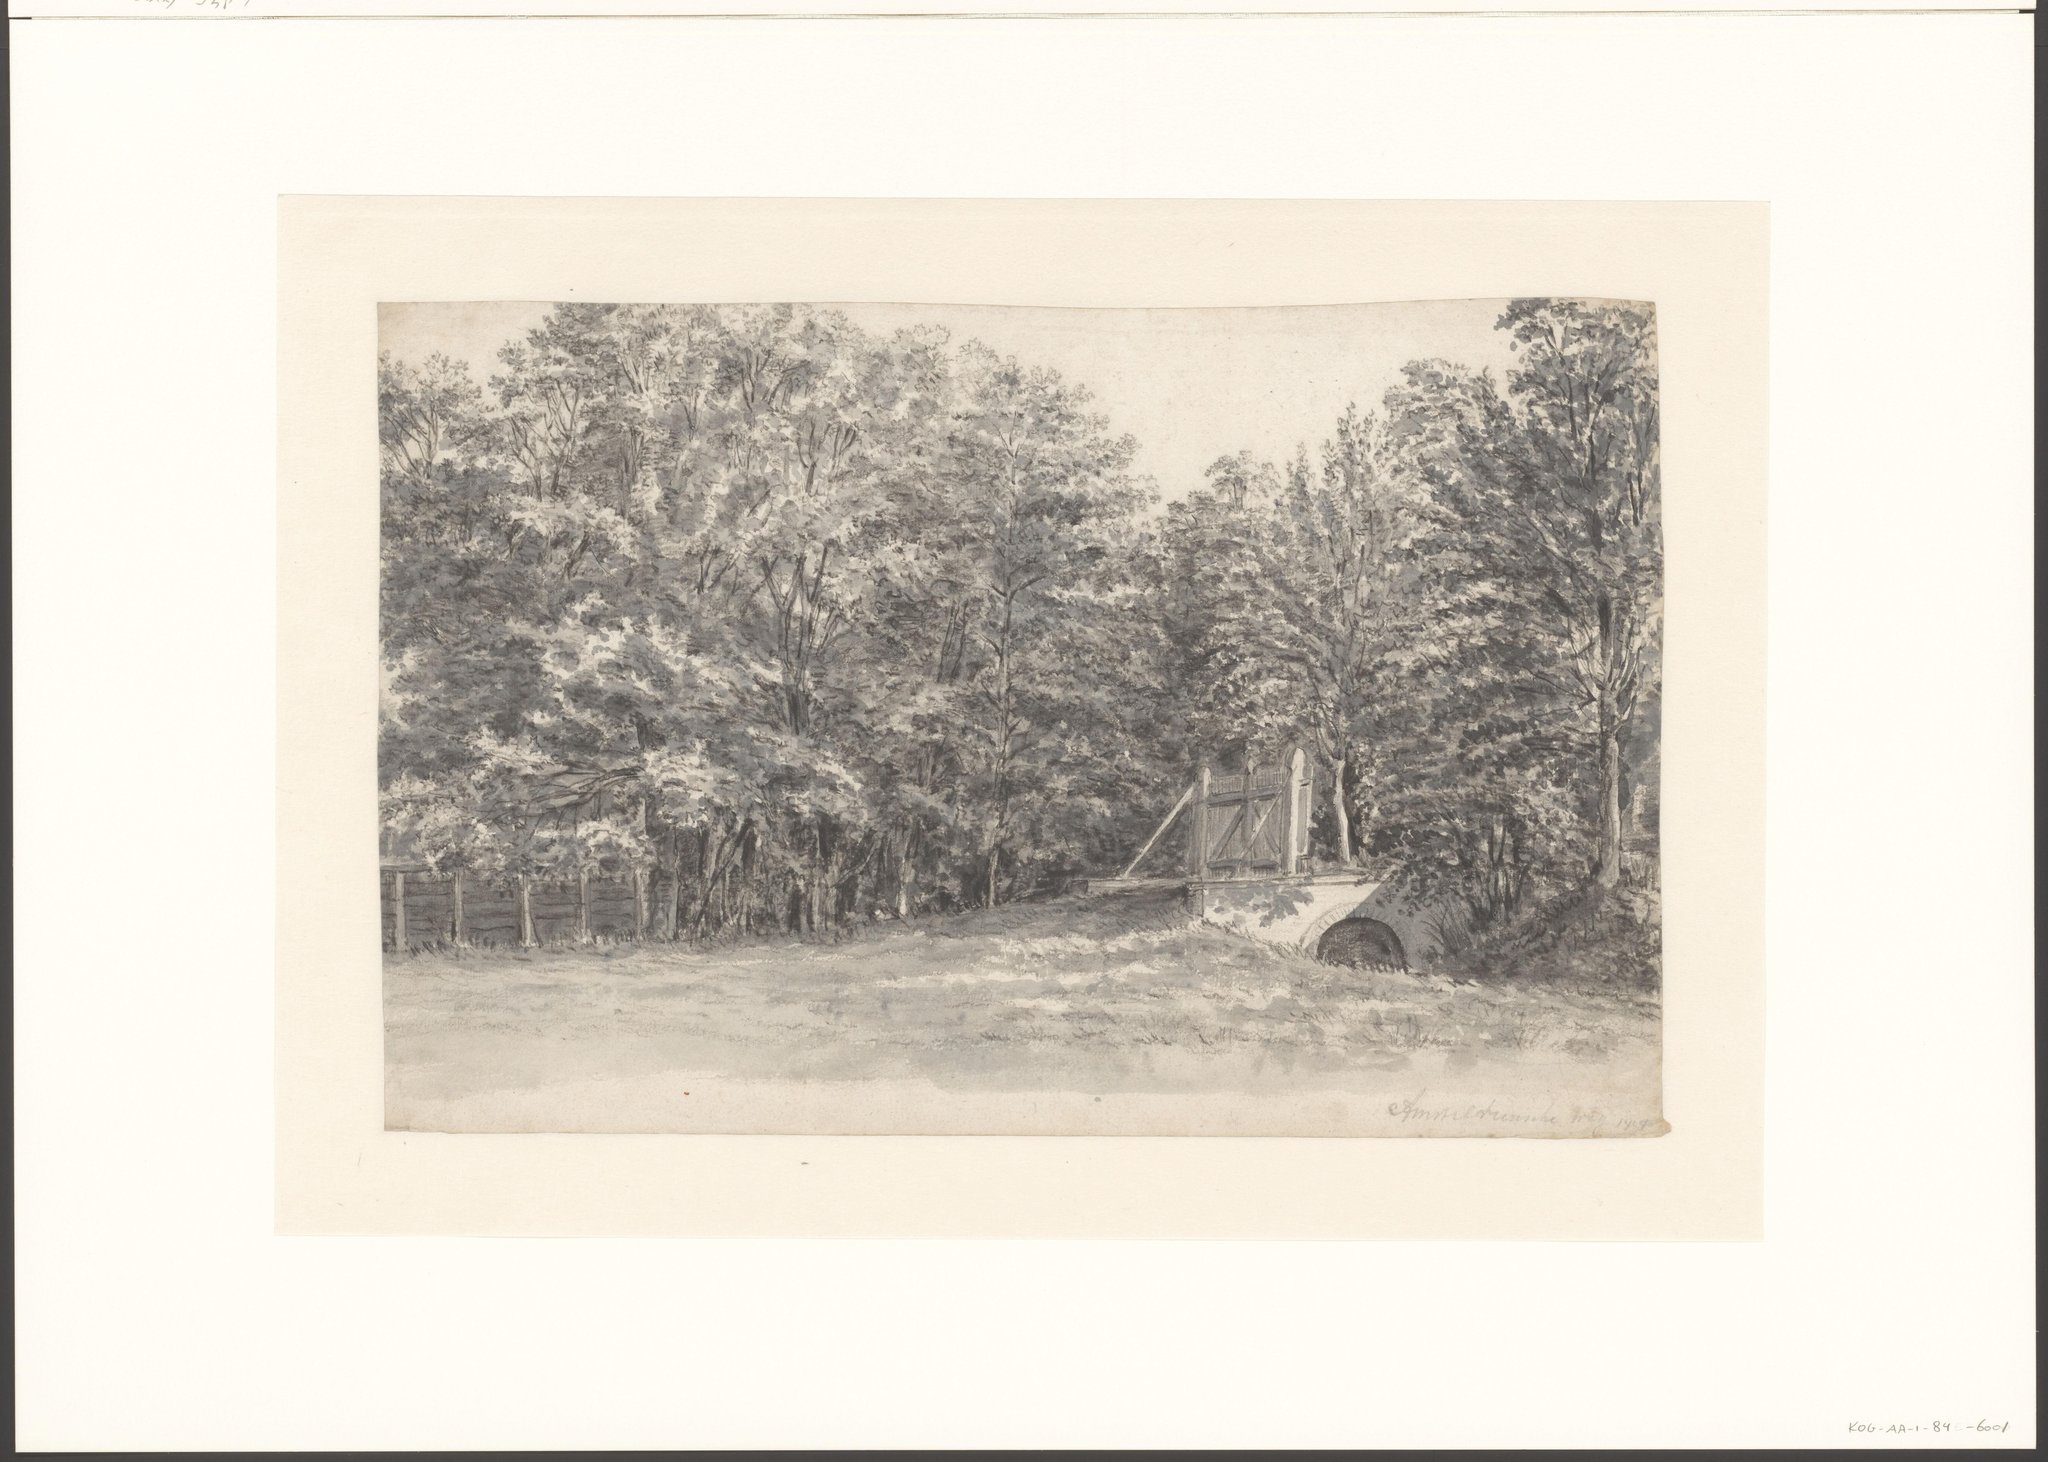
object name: drawing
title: Gezicht op de Amstelveenseweg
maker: Anonymous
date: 1919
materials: chalk, ink, paper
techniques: brush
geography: amsterdam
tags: city-view in general; 'veduta', road, path, bridge in village across river, canal, etc.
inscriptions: inscription: ‘Amsterdamsche weg 1919’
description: Onderwerpsrubriek binnen de Atlas Amsterdam: Amstelveenseweg.